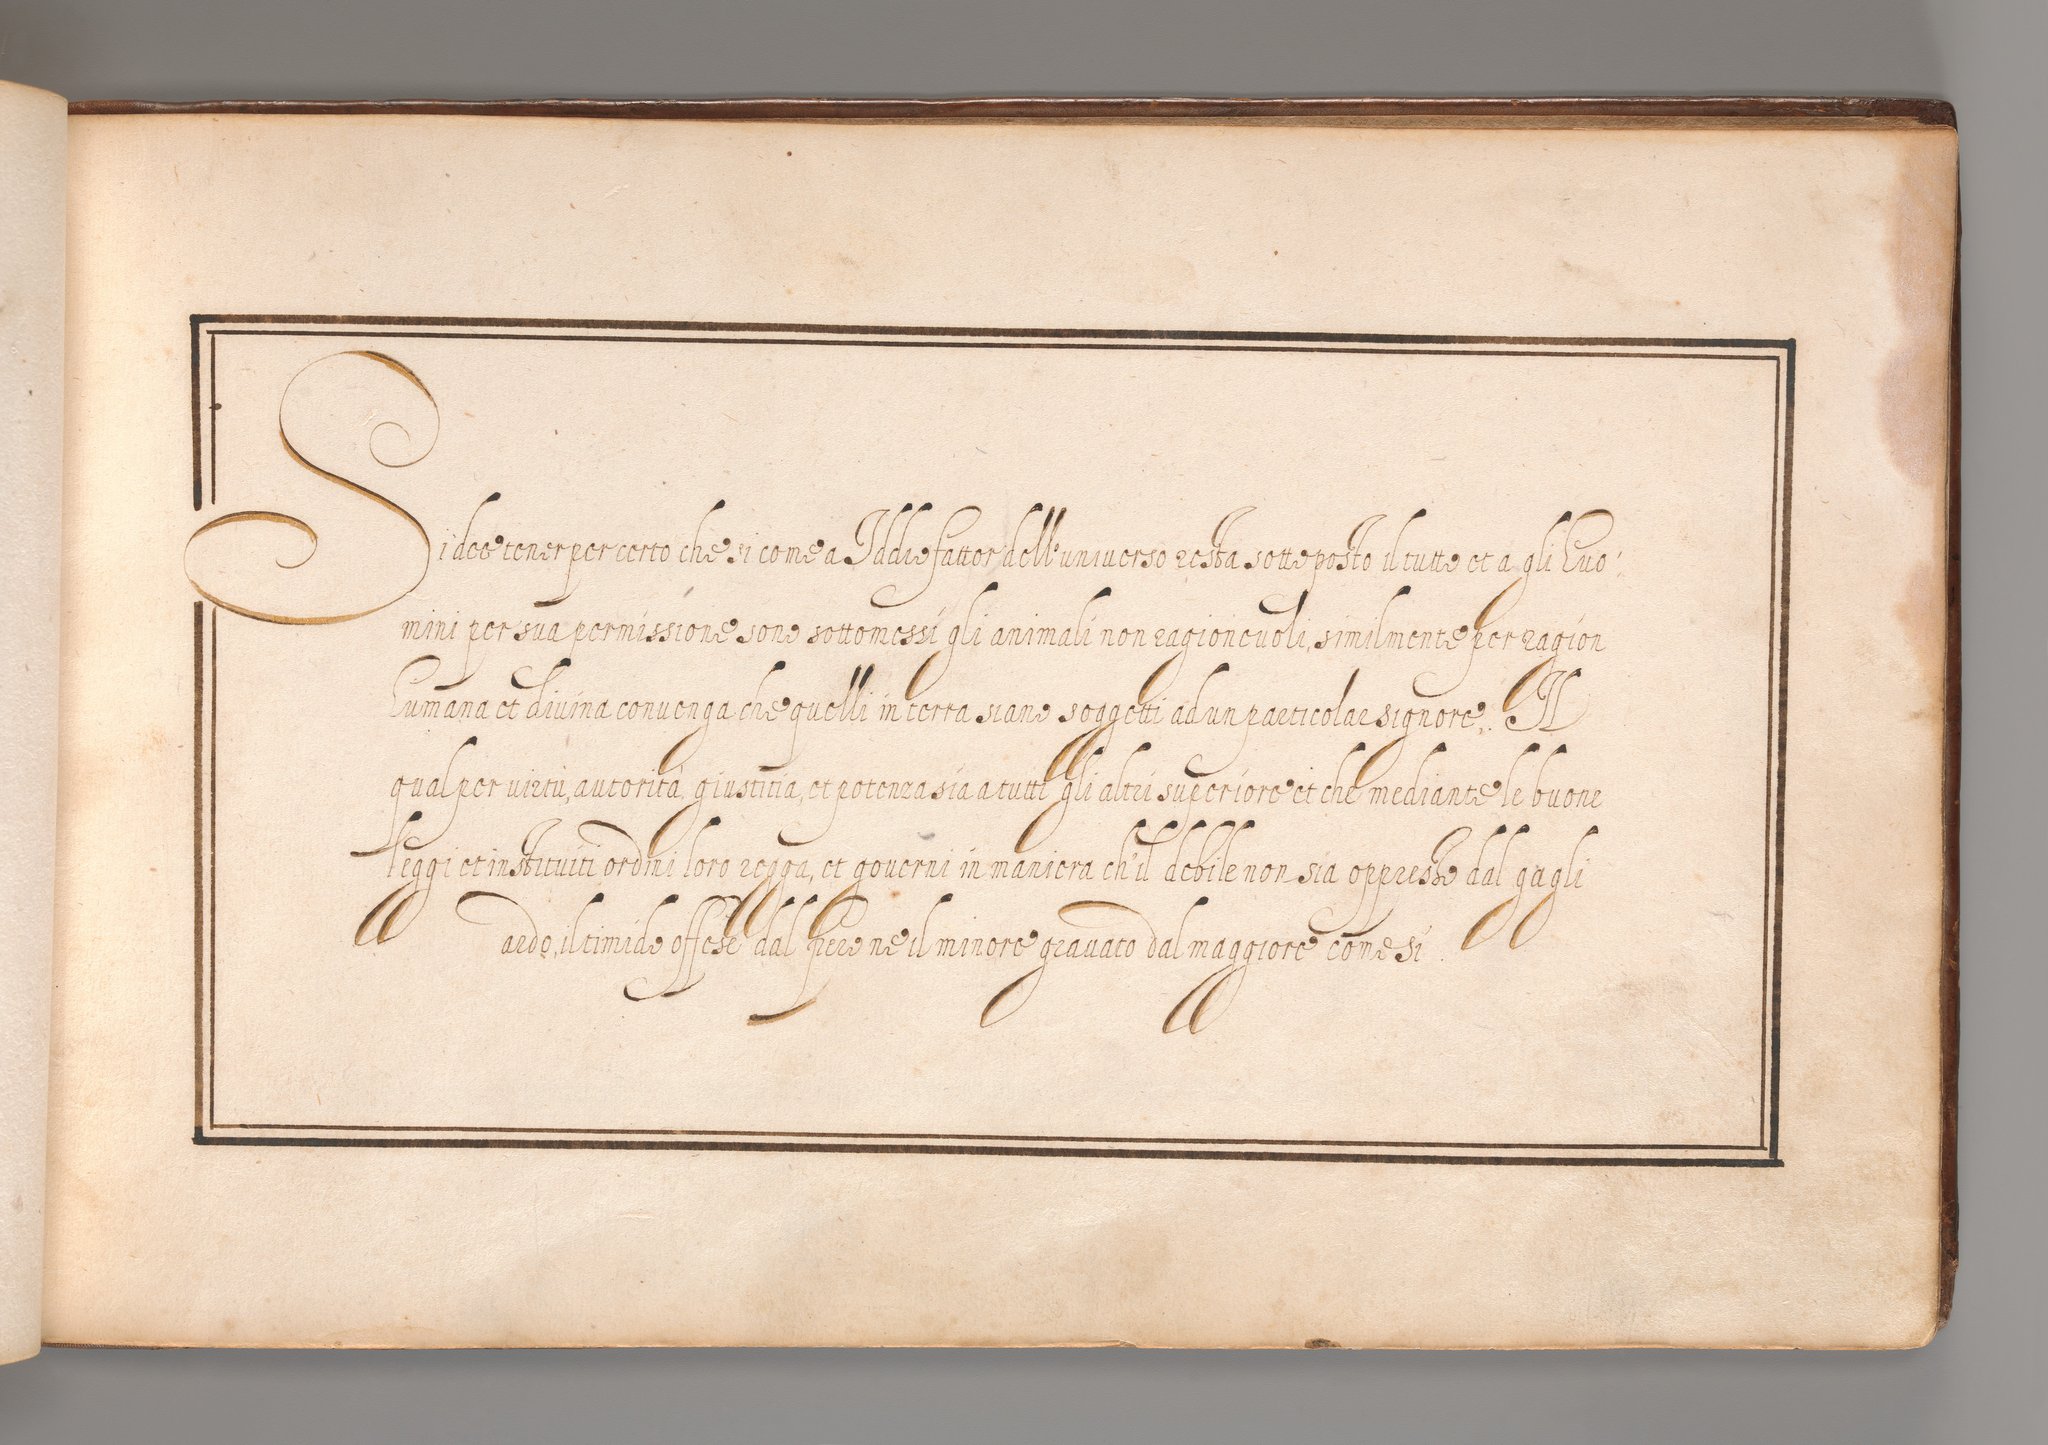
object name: album print ornament architecture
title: Calligraphic Exercise in Italian (Cursive Script)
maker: Anonymous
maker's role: artist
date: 1601-1633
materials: ink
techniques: pen